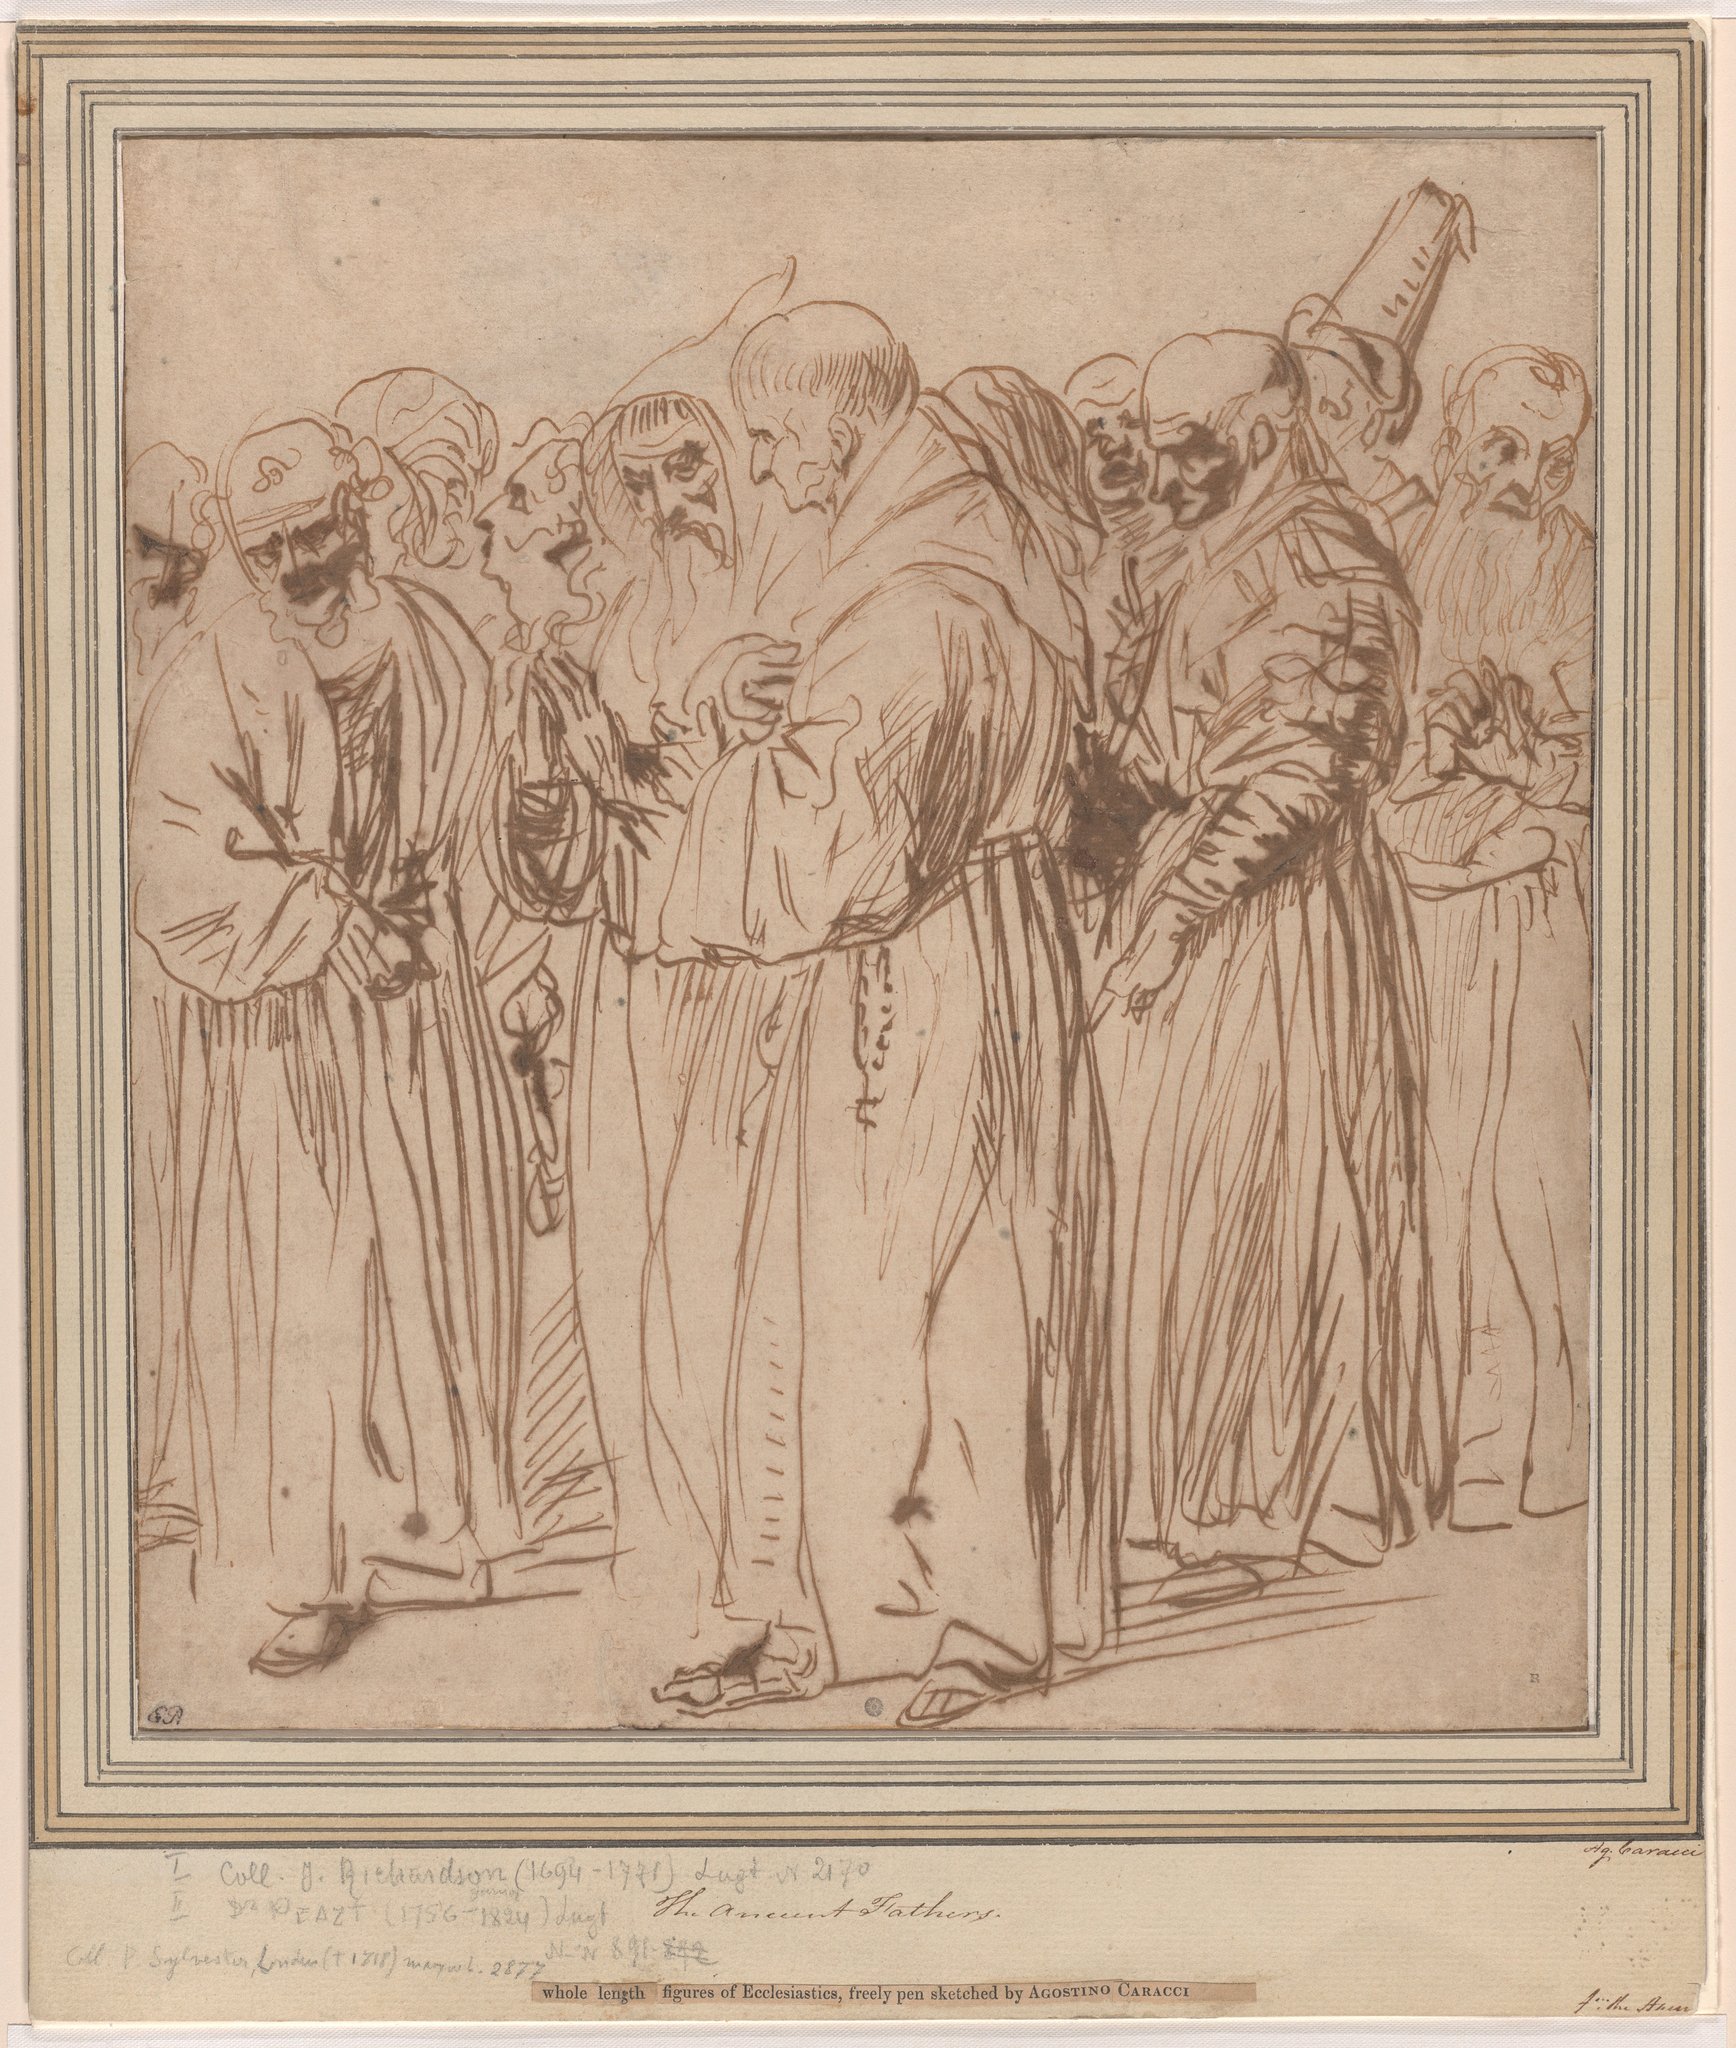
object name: drawing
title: A Group of Standing Monks and other Figures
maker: jan lievens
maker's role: artist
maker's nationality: dutch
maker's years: 1607-1674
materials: ink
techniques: pen